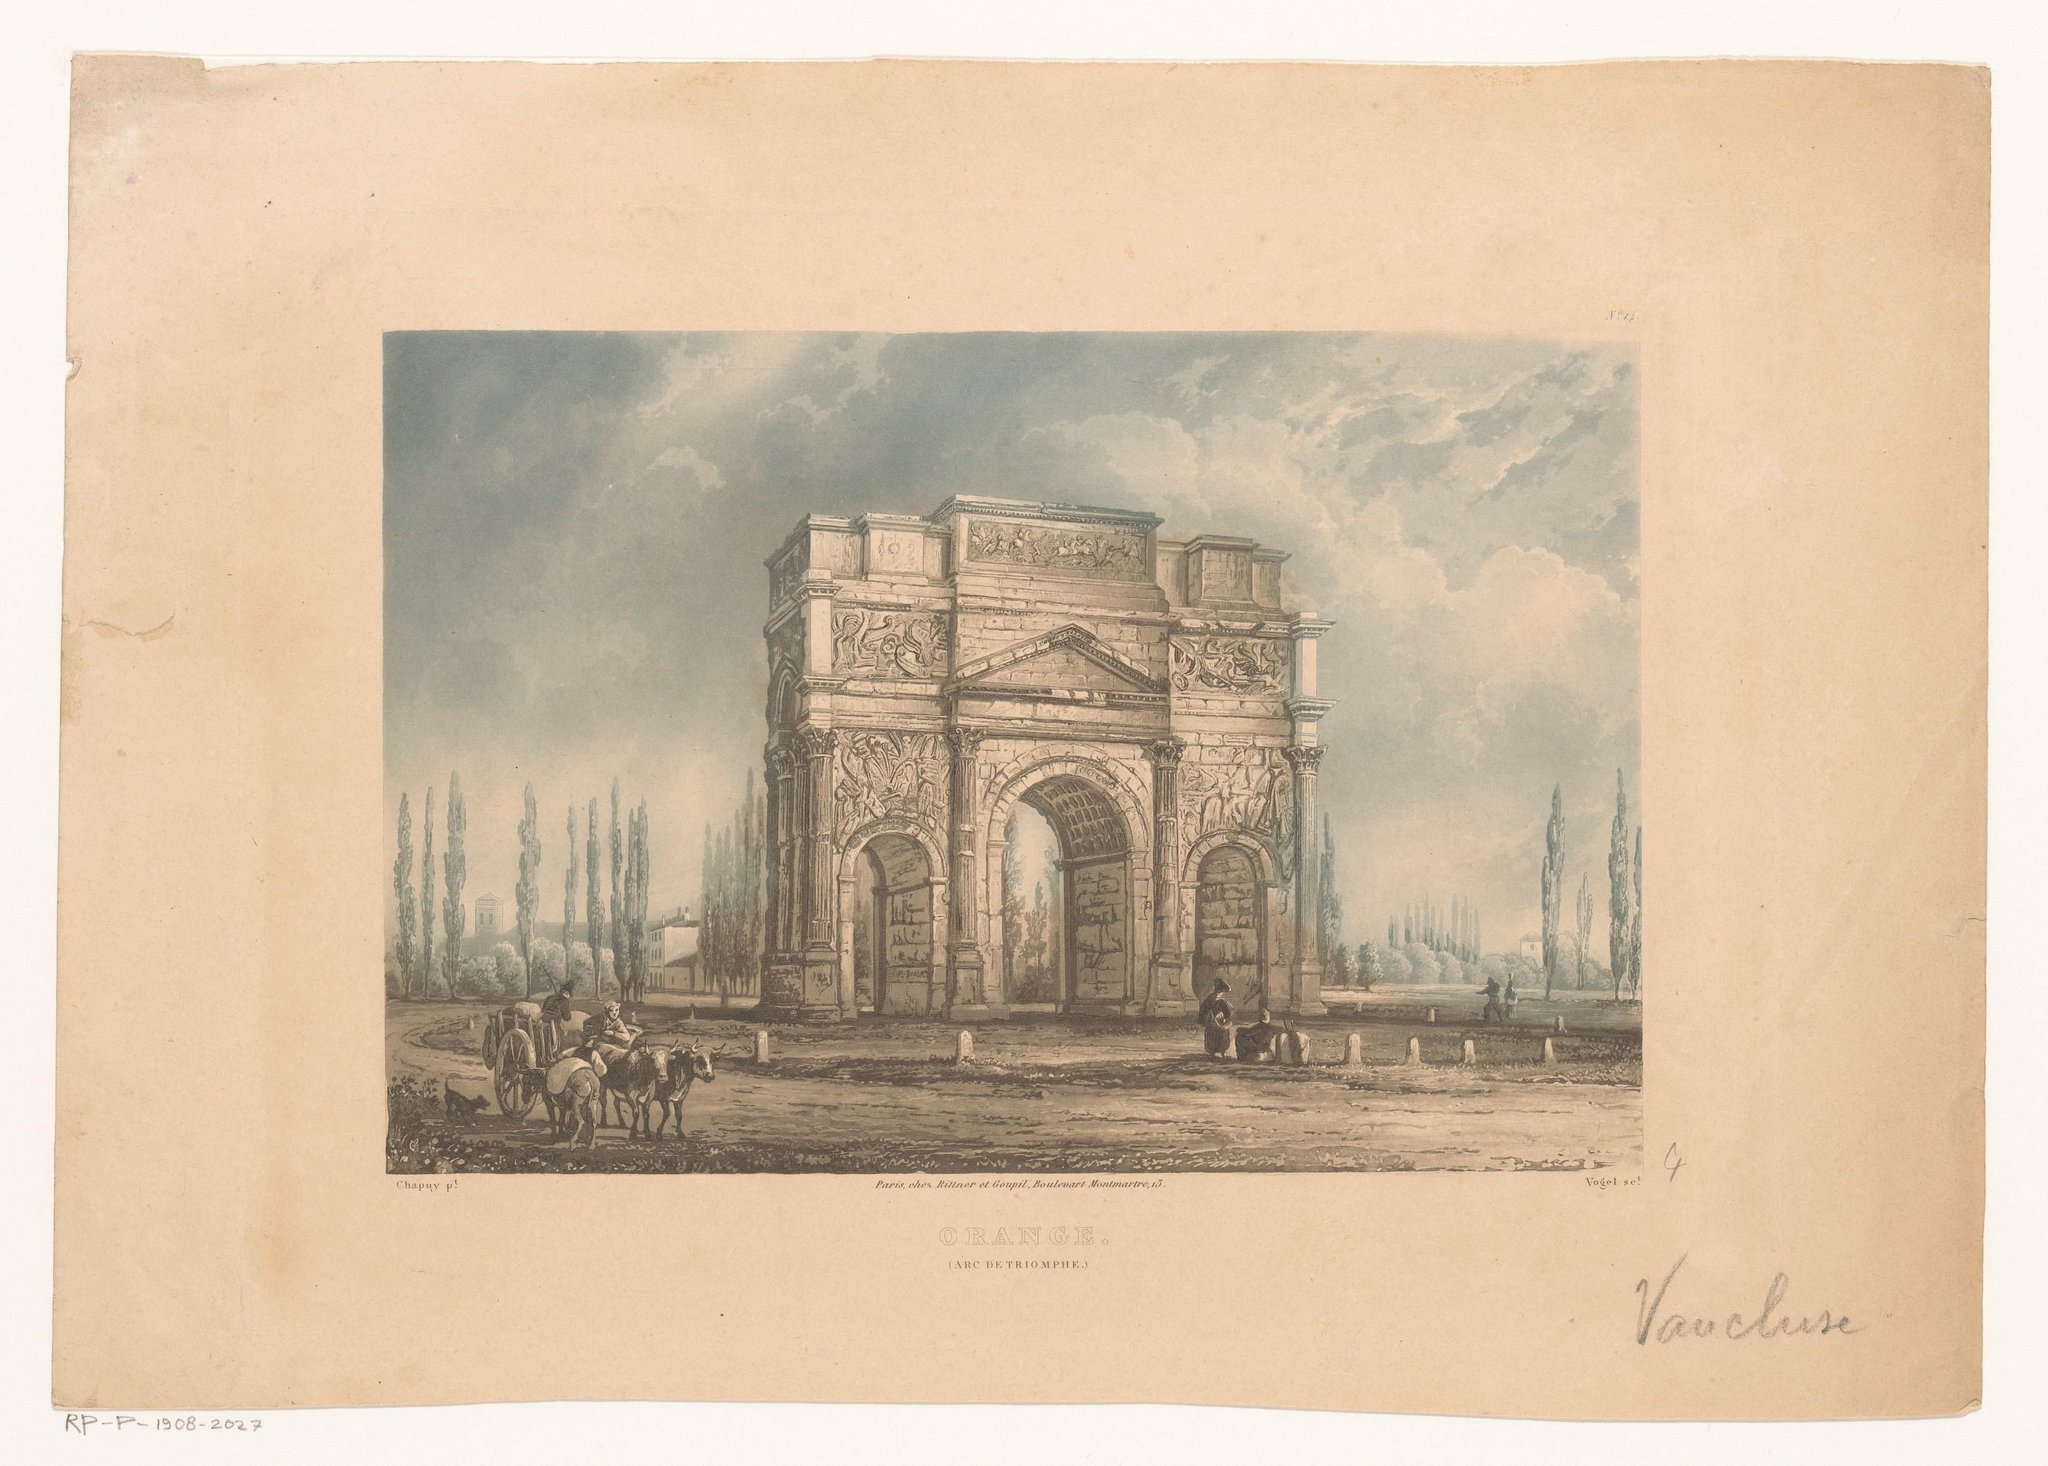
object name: print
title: Orange. (Arc de Triomphe)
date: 1829-1840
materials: paper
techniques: aquatint, etching, lithography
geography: france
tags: triumphal arch, landscapes (+ landscape with figures, staffage)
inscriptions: collector's mark: Lugt 2228